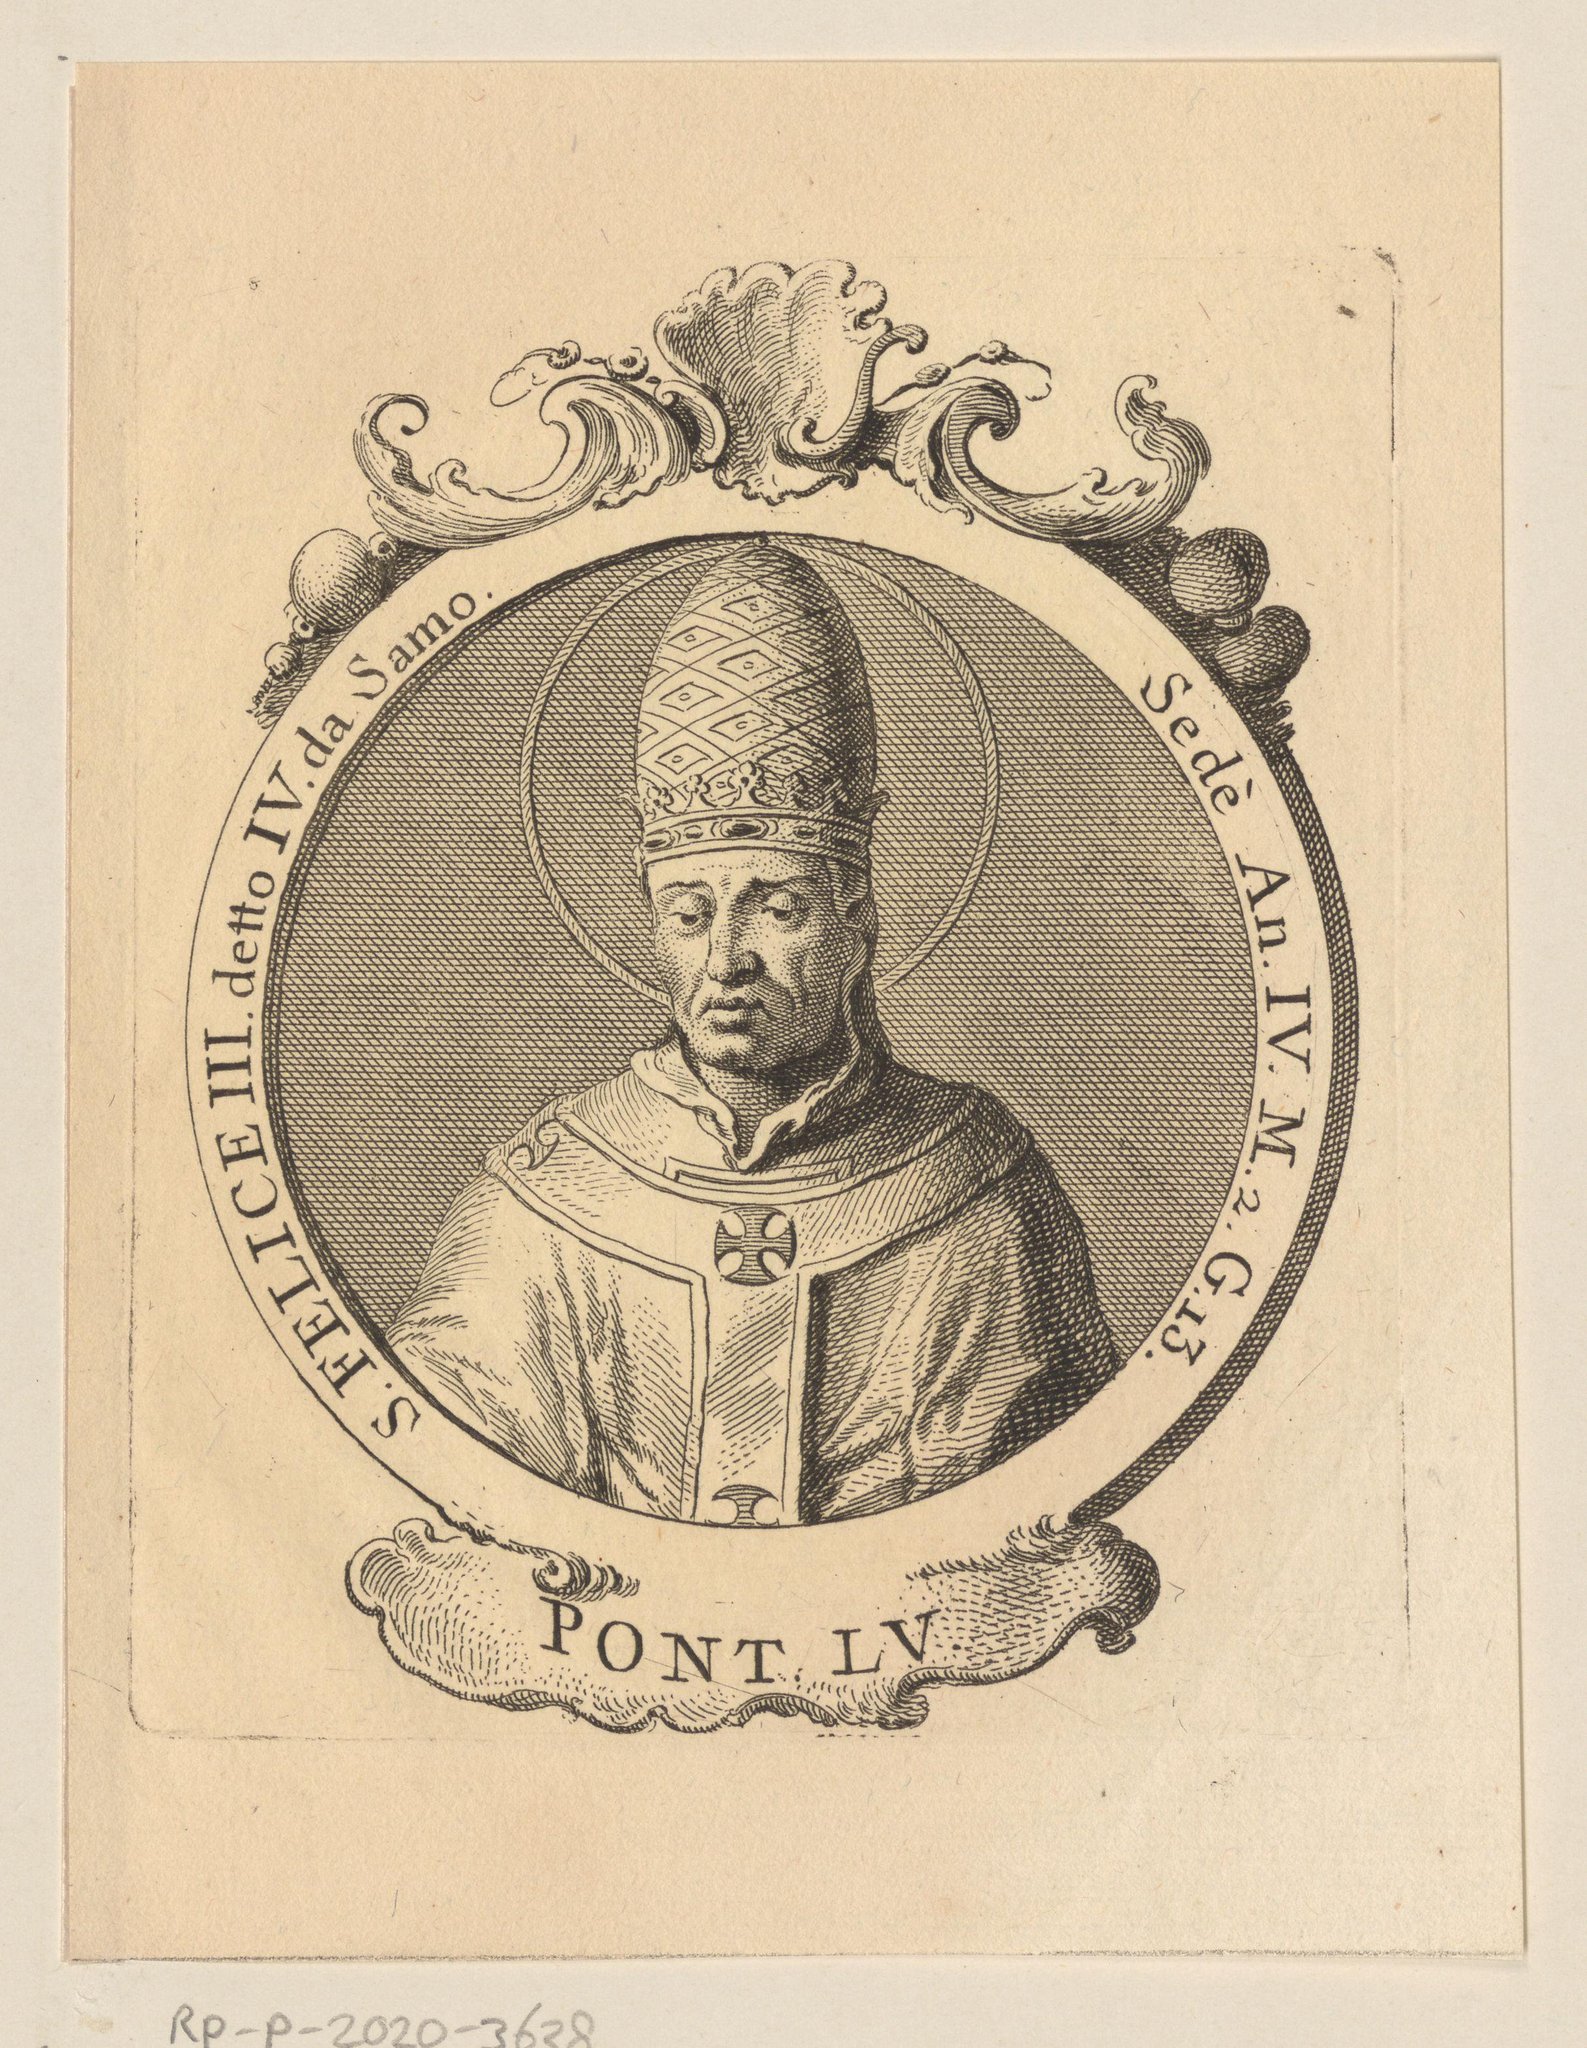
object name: book illustration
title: Portret van paus Felix III (IV)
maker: Anonymous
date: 1775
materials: paper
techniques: etching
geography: italy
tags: rome, historical persons, pope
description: Prent waarschijnlijk uit: Effigies Romanorum pontificum a S. Petro ad Pium VI (...). 2 dln. Venetië en Bassano del Grappa: Giuseppe Remondini, 1775. Prent met tekst in boekdruk op verso gebruikt in een deel van: Platina (Bartholomaeus Sacchi). Storia delle vite dei pontefici da Platina e d'altri autori (...). 5 dln. Venetië: Domenico Ferrarin, 1760-1769.